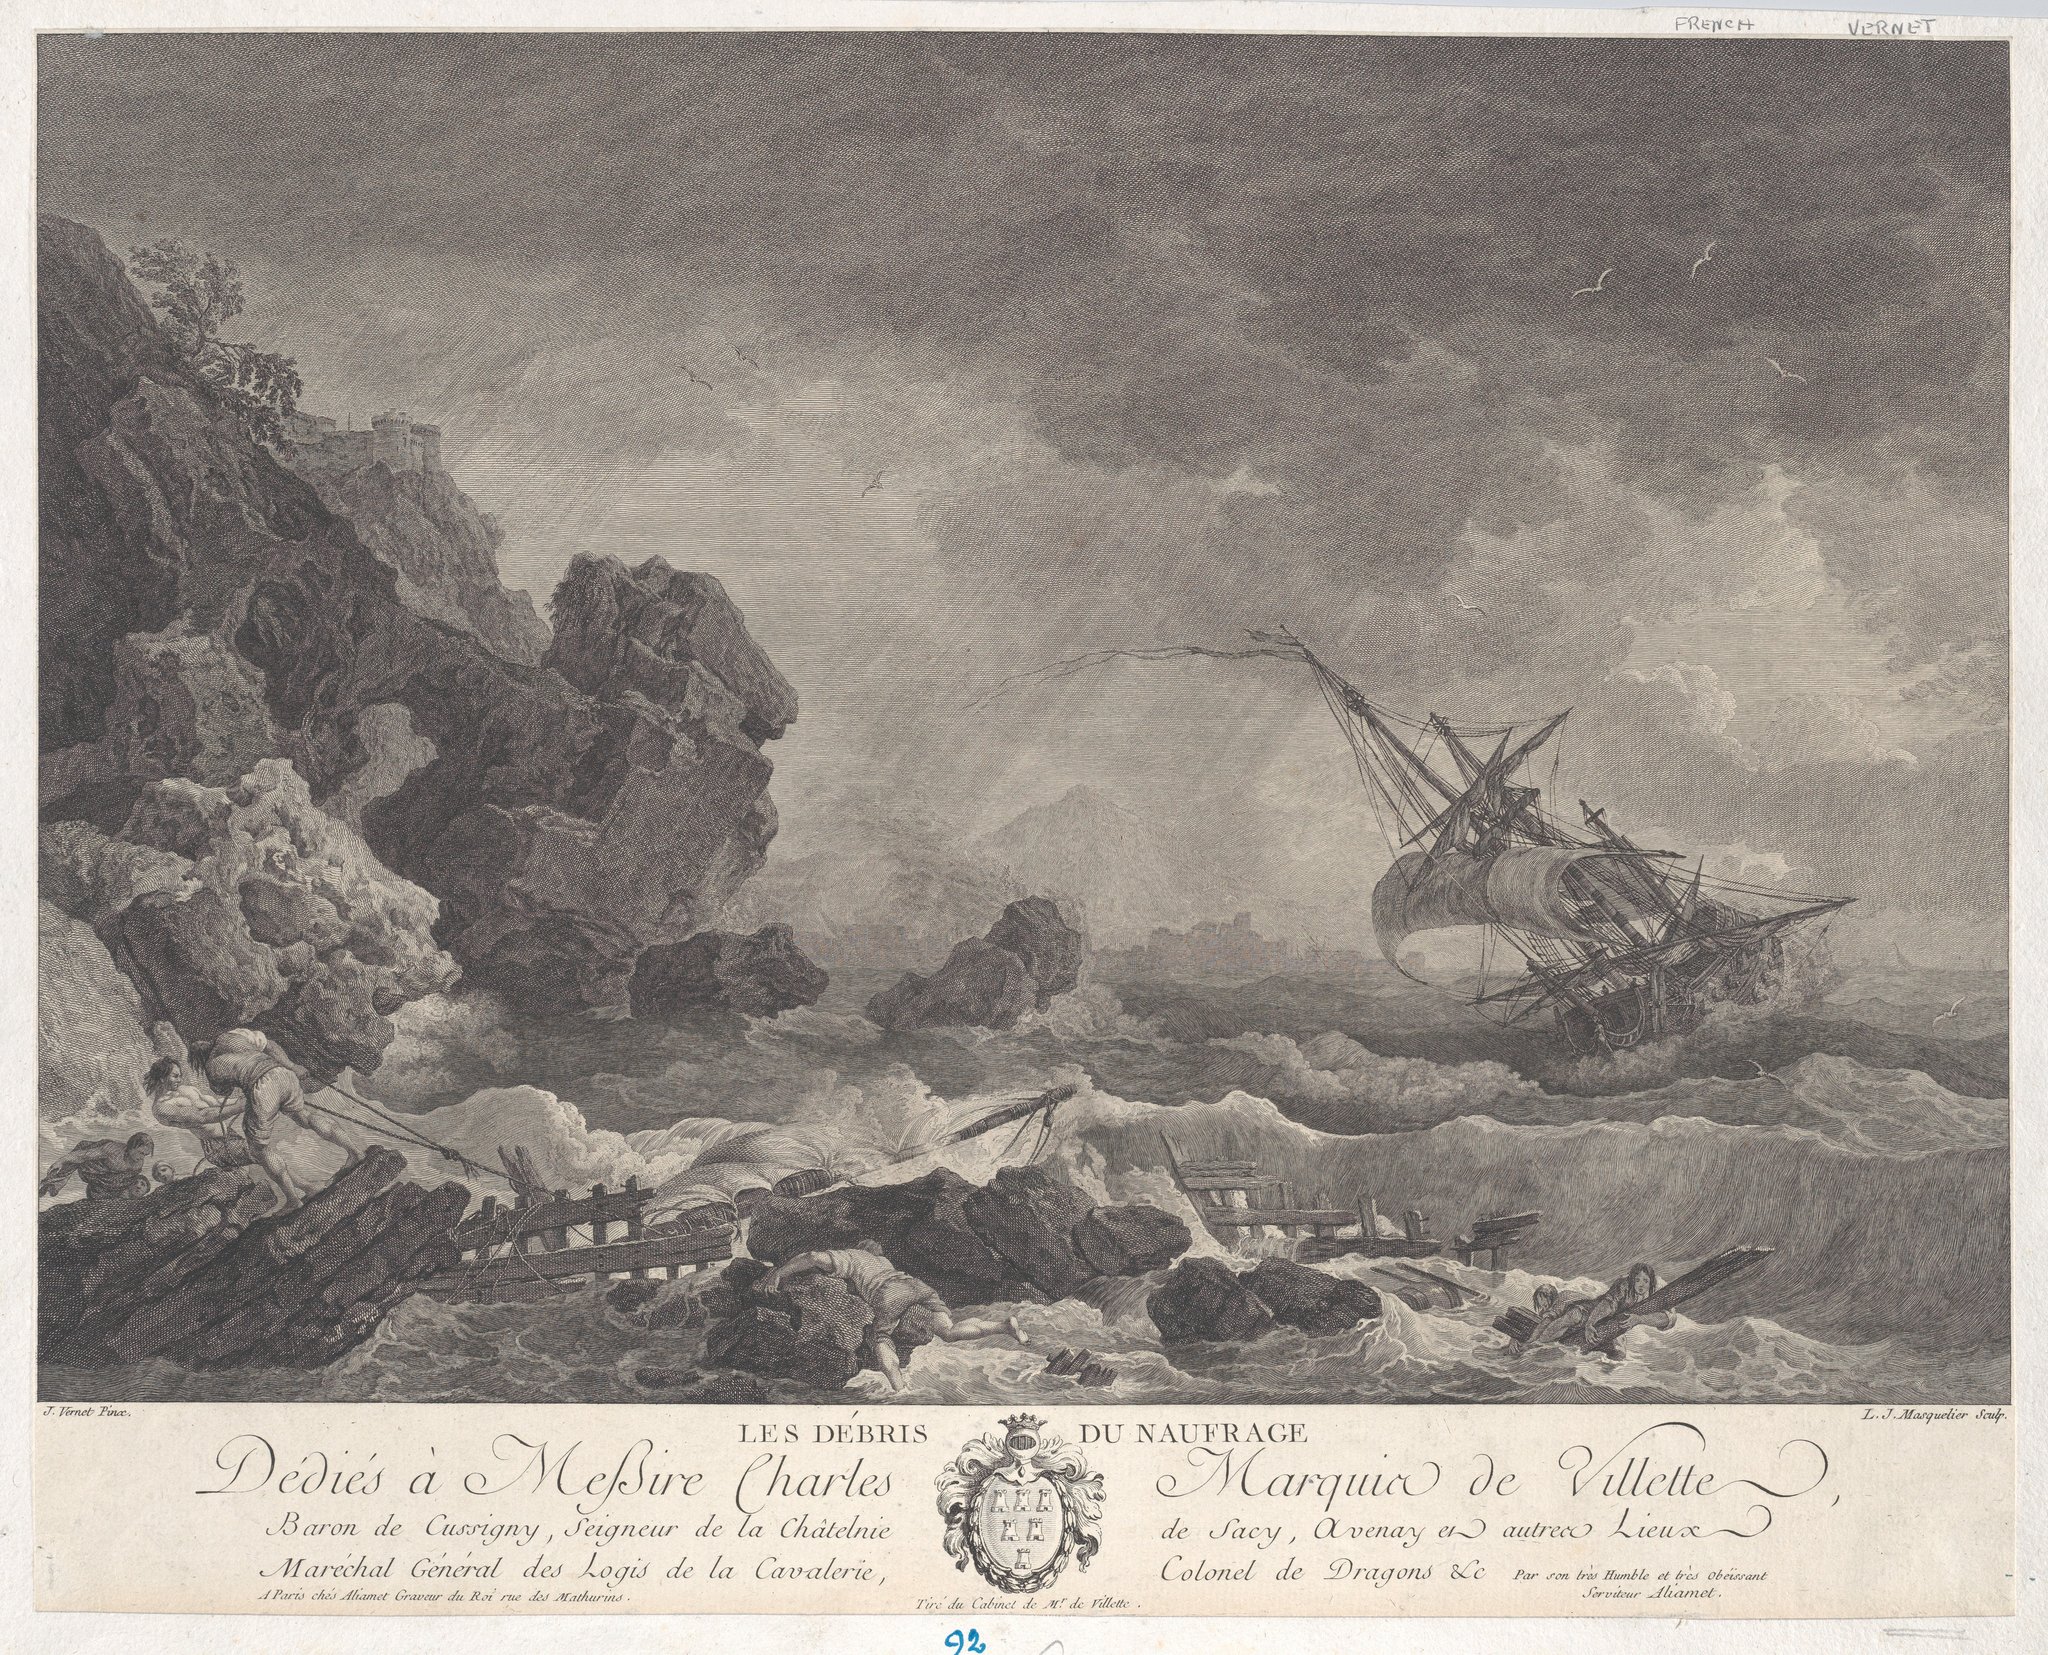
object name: print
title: The Debris of the Shipwreck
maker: joseph vernet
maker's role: artist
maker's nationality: french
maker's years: 1714-1789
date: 1756-1788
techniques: engraving